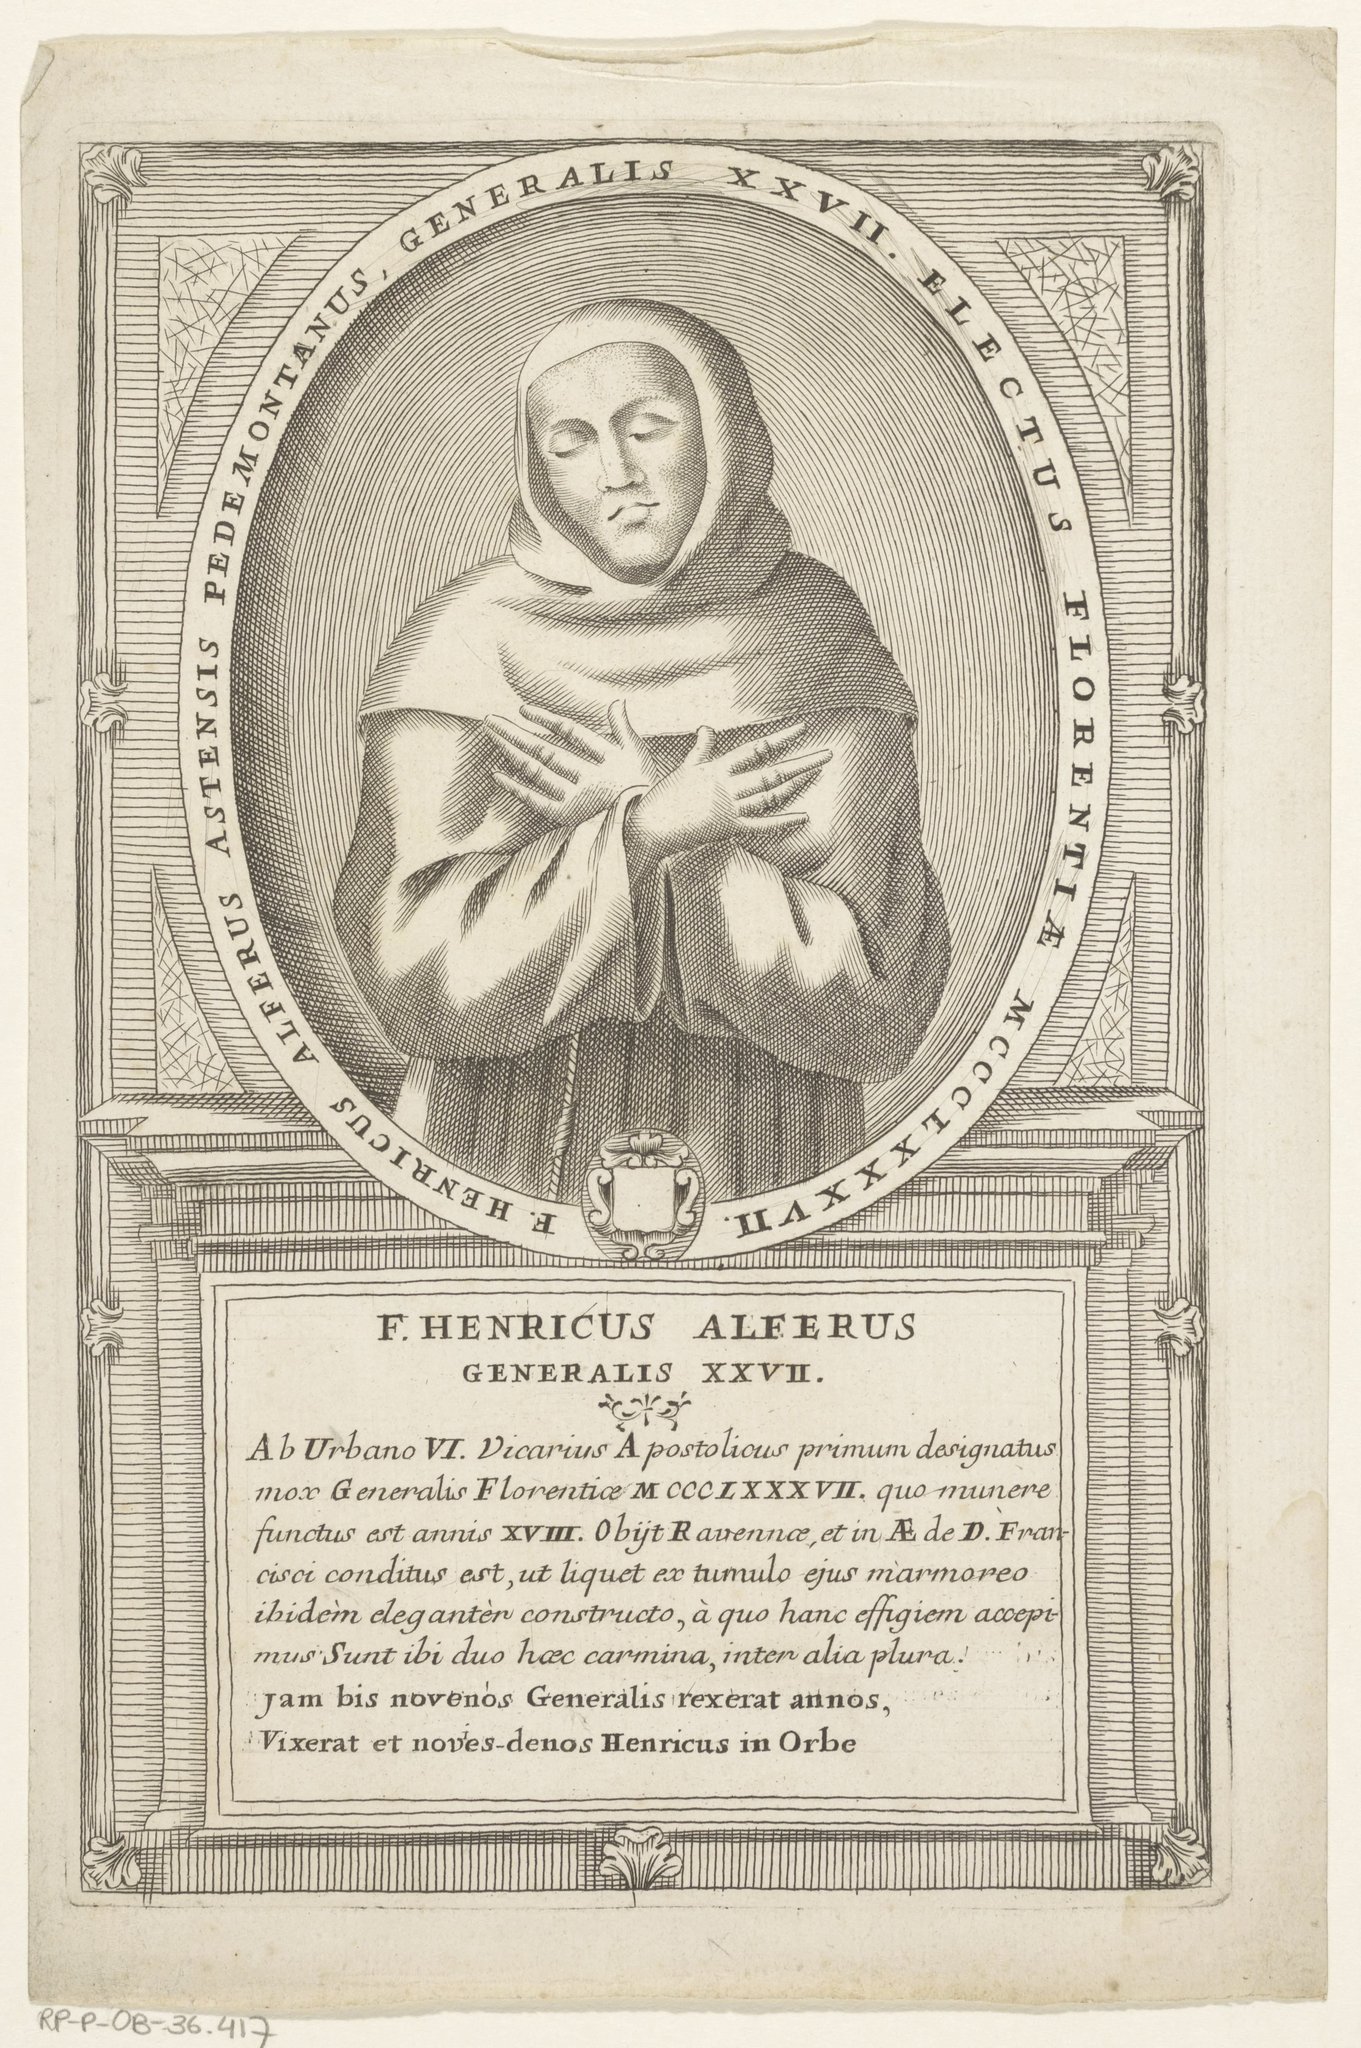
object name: print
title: Portretten van Ministers Generaal van de franciscaner orde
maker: antonio luciani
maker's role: print maker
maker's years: 1700-1738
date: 1710-1738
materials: paper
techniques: engraving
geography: italy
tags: clergyman, historical persons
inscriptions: collector's mark: Lugt 2228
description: Deze prent maakt deel uit van een groep van 60 portretten.